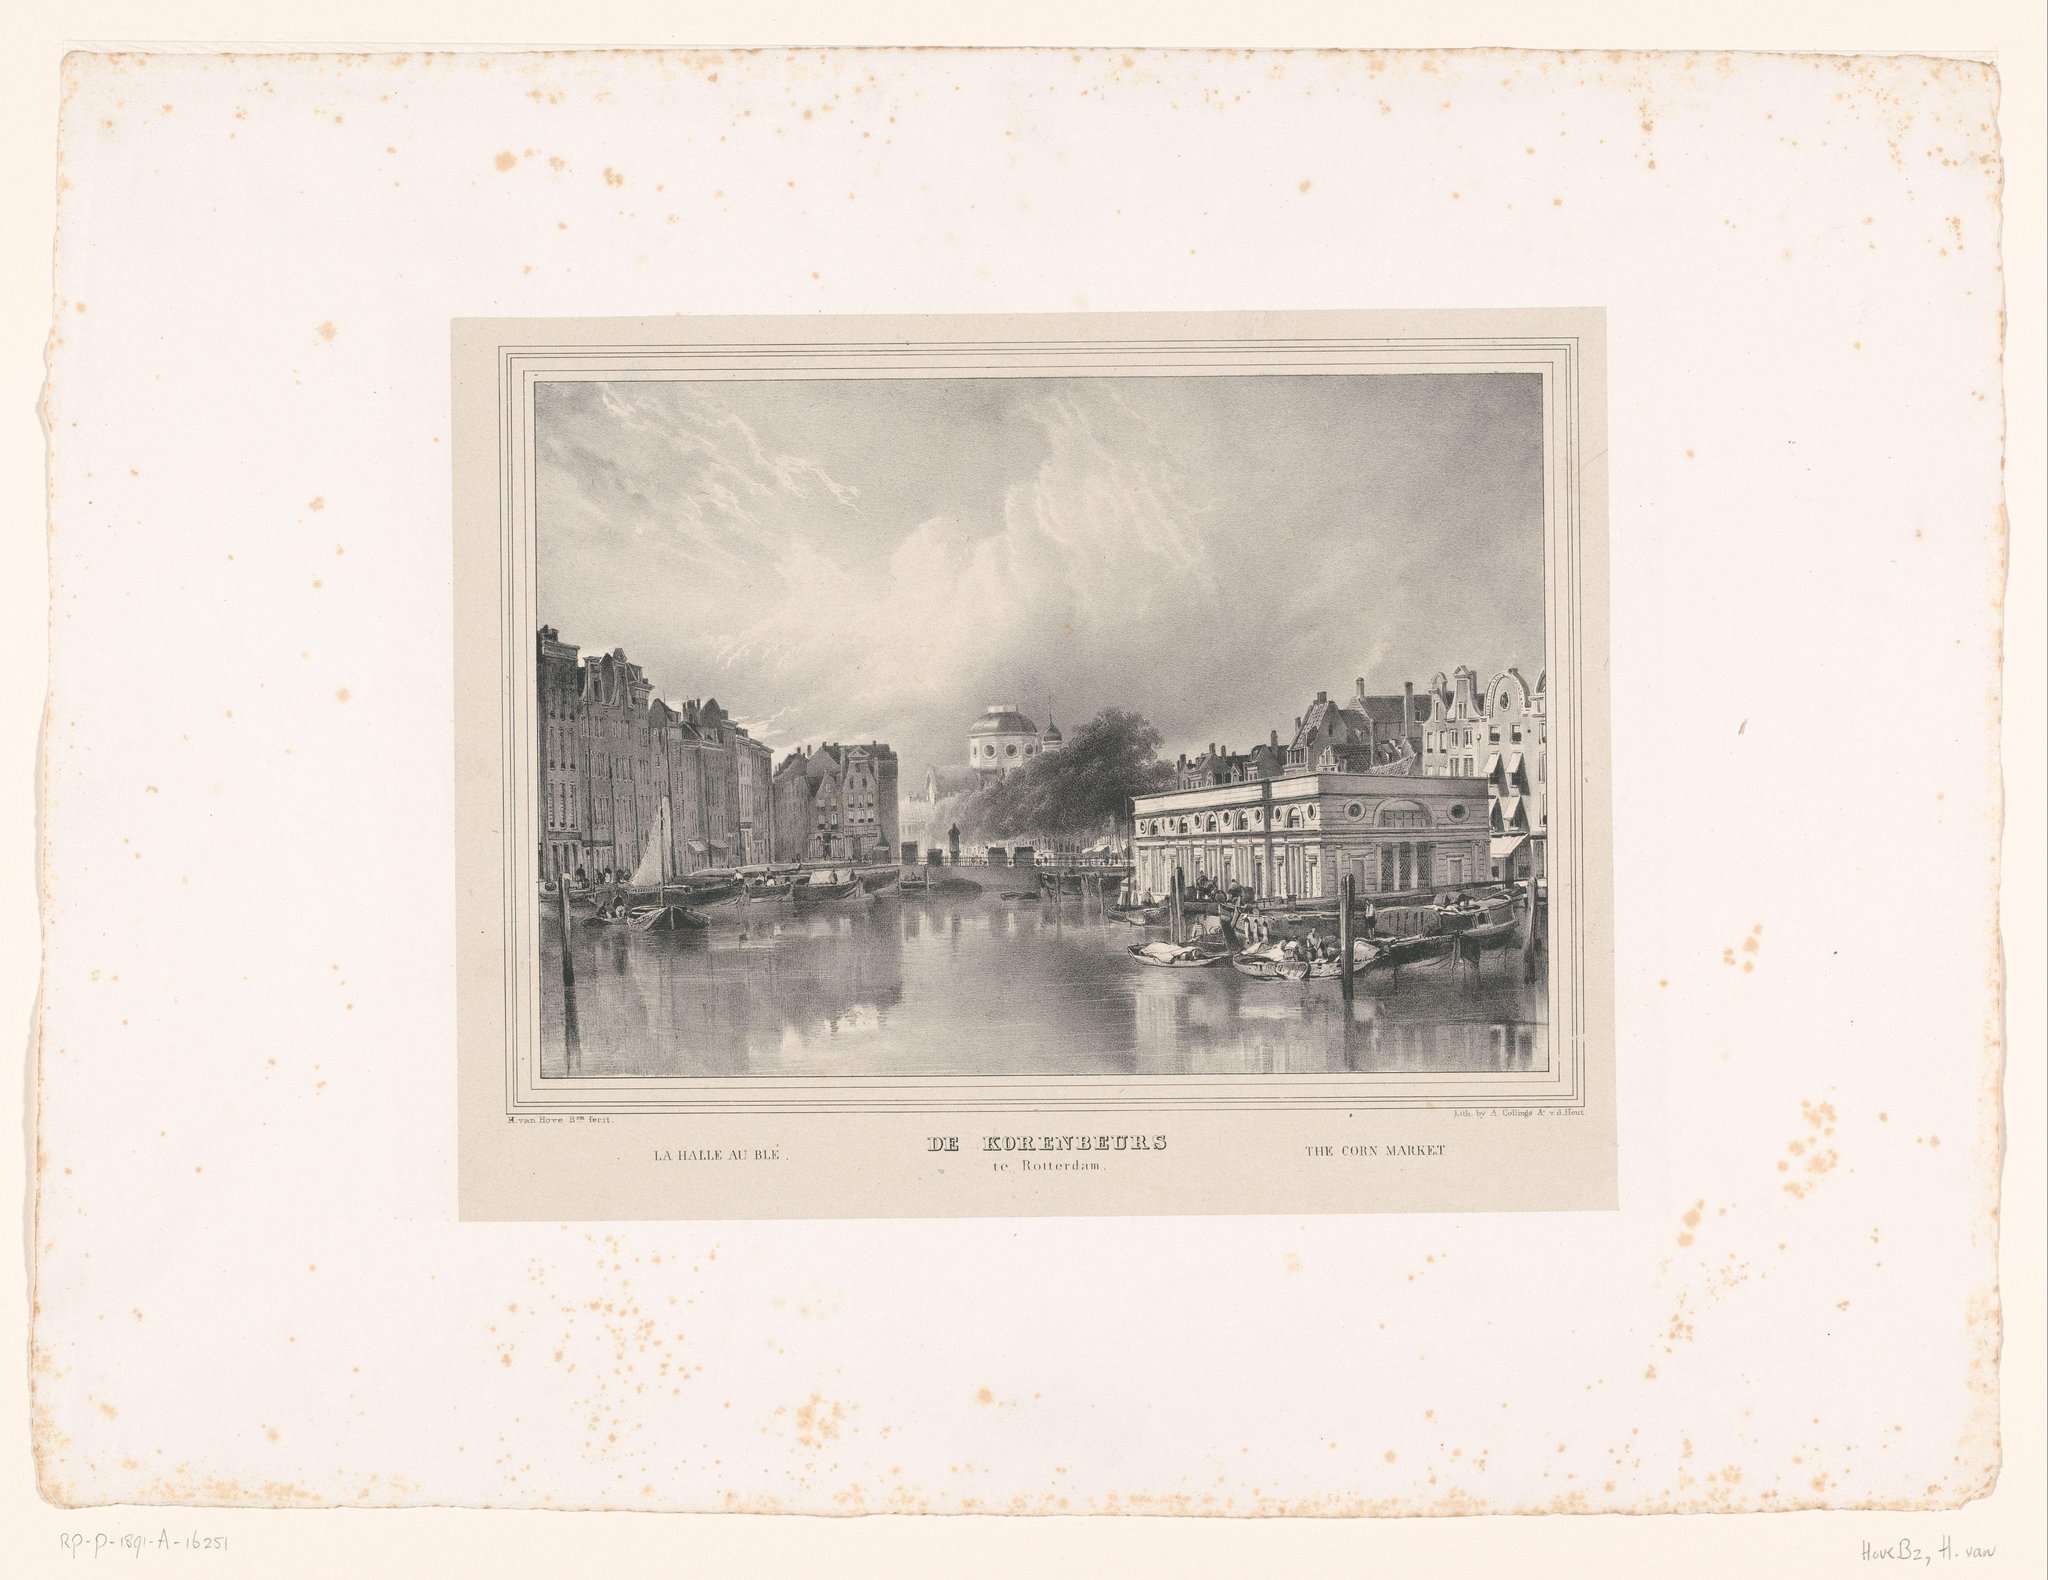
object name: print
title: Gezicht op de Korenbeurs te Rotterdam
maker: huib van hove bz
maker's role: painter, print maker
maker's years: 1814-1867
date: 1835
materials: paper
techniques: lithograph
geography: rotterdam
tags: city-view in general; 'veduta'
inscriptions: collector's mark: Lugt 2228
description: Gezicht op een gracht met in de achtergrond de Korenbeurs te Rotterdam. Prent is onderdeel van een omslag met een serie van acht lithografieën van gezichten te Rotterdam.